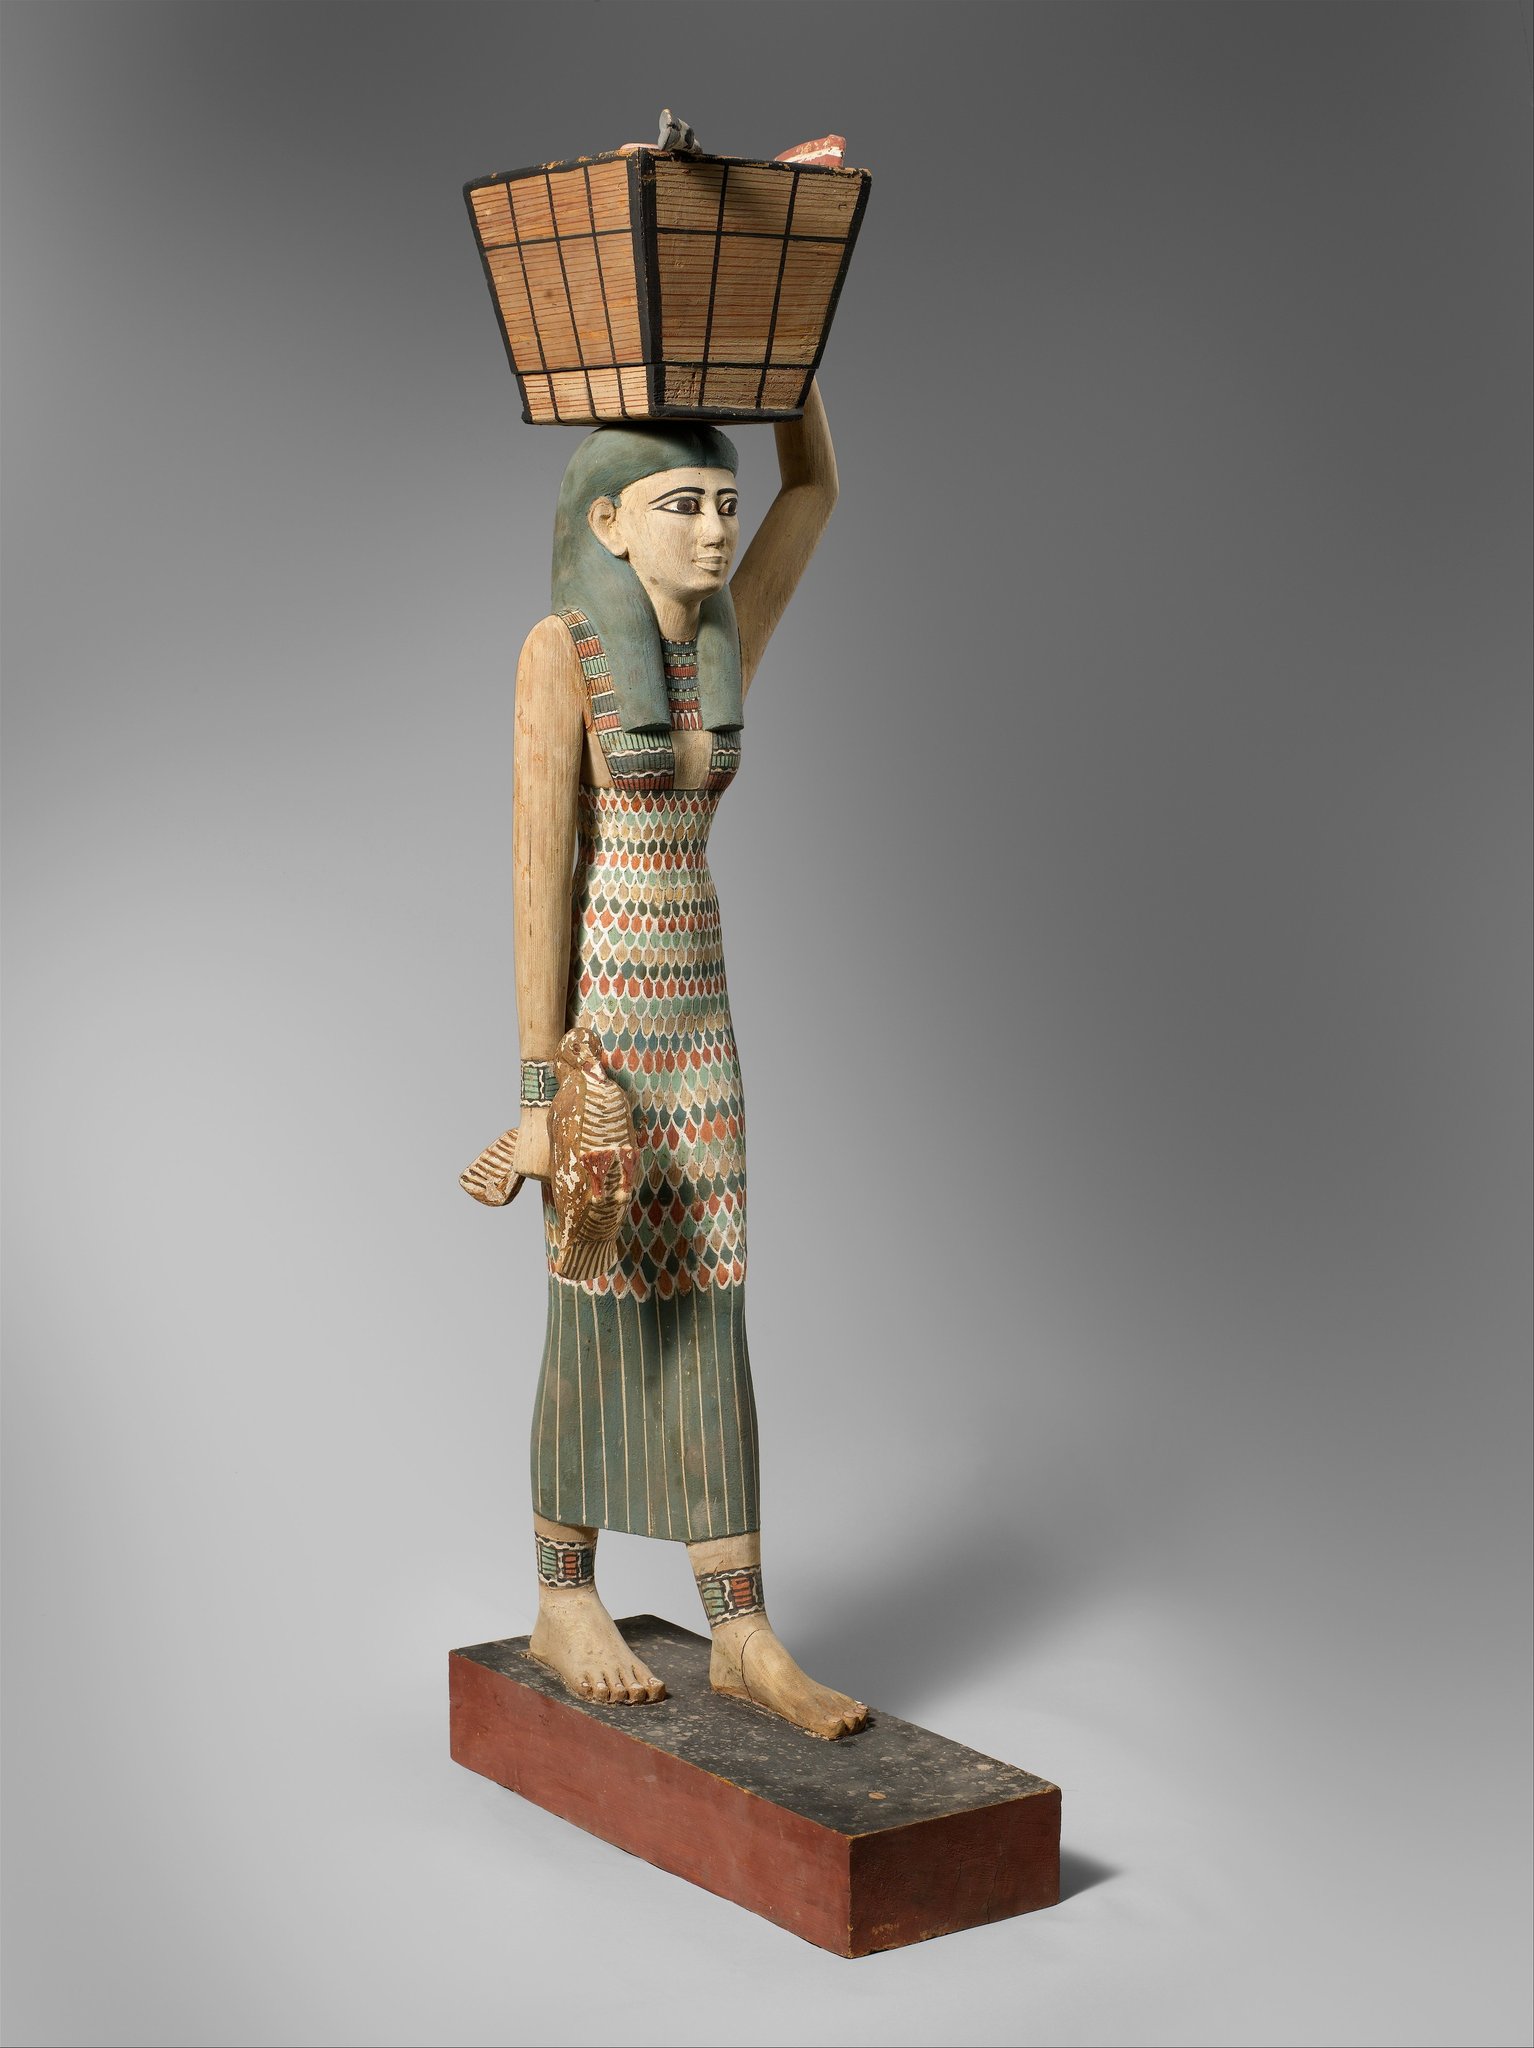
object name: statue, standing woman, offering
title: Estate Figure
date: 1981-1975 BCE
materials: gesso, paint, wood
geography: egypt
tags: ducks,women,meketre-models